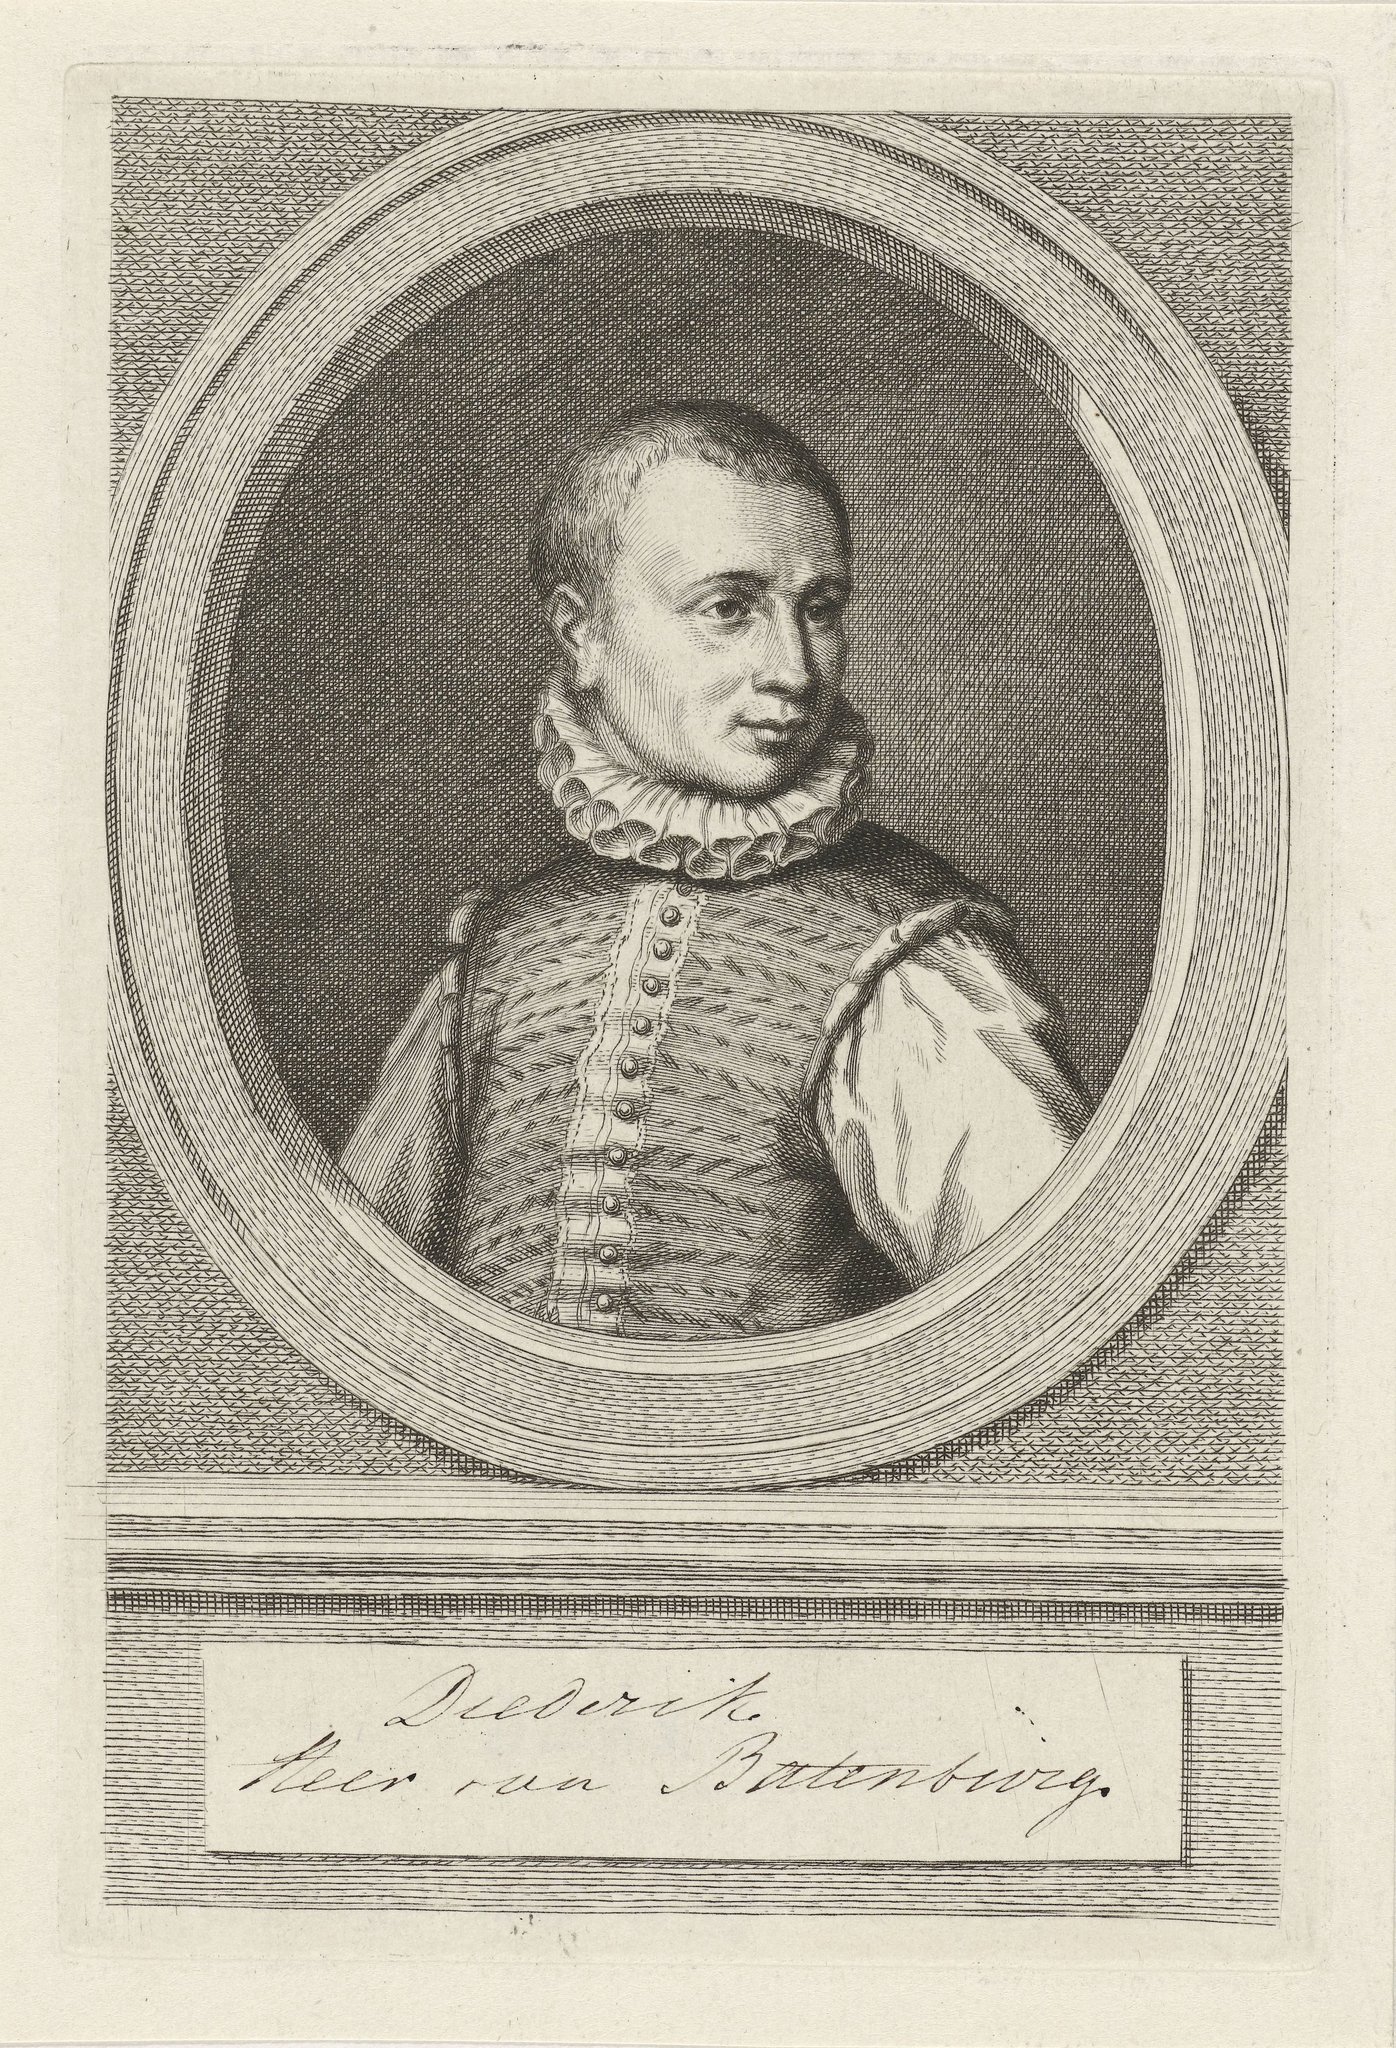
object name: print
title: Diedrik Heer van Batenburg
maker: jacob houbraken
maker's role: draughtsman, print maker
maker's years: 1698-1780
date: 1747-1749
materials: paper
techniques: engraving, pen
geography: amsterdam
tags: brussels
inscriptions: inscription: ‘Diedrik / Heer van Batenburg’, collector's mark: Lugt 2228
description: Proefdruk van de prent oorspronkelijk bedoeld voor: Jan Wagenaar, Vaderlandsche historie, vervattende de geschiedenissen der nu Vereenigde Nederlanden, inzonderheid die van Holland (...), 21 delen. Amsterdam, Isaak Tirion, 1749-59.